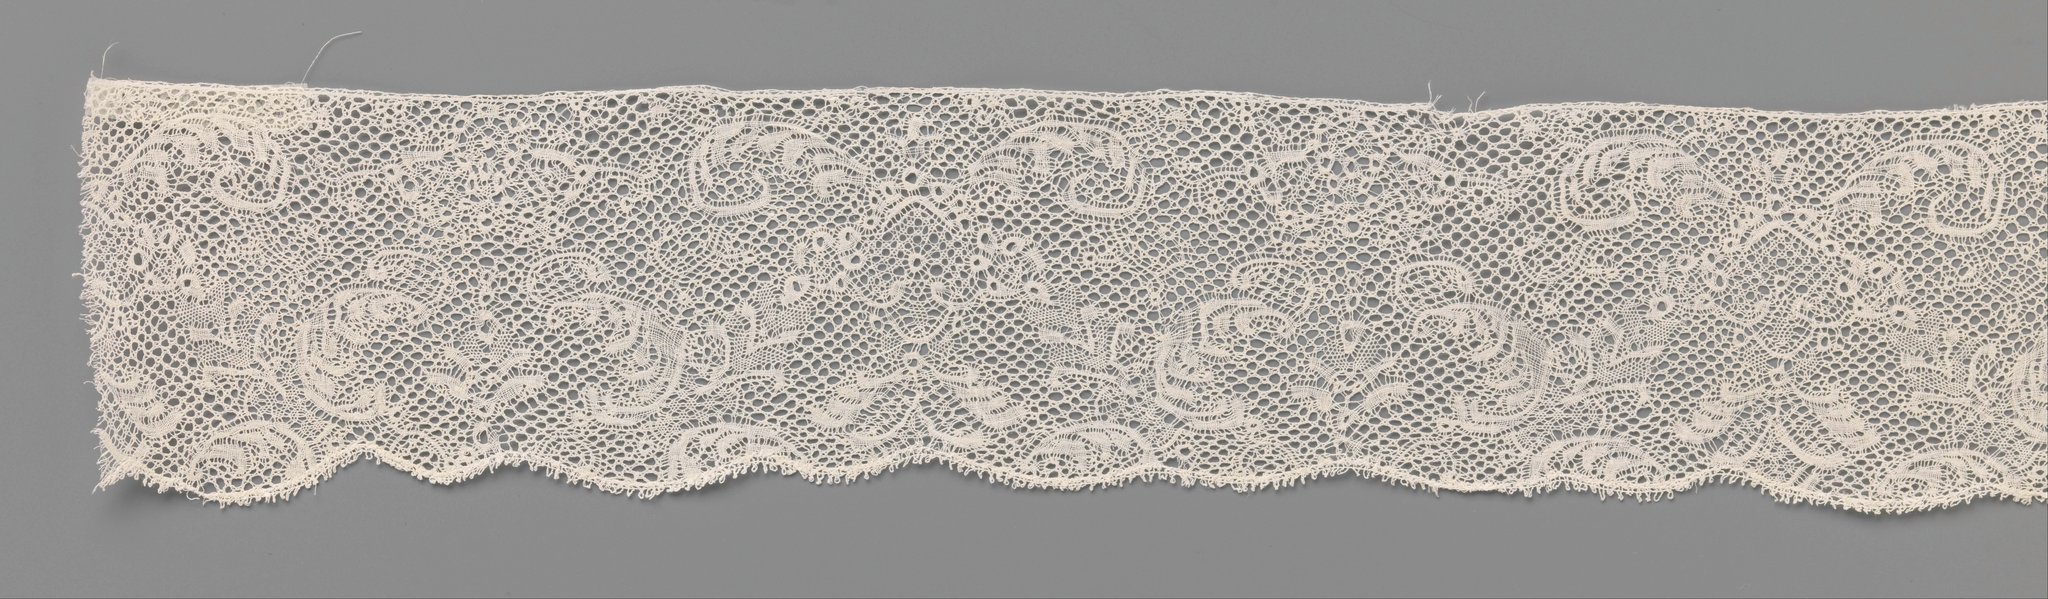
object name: strip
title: Strook kloskant met twee tegen elkaar geplaatste driehoekige composities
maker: Anonymous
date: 1690-1710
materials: linen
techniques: lace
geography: southern netherlands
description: Strook naturelkleurige kloskant, Binche-kant. Het zich herhalende en ijle patroon bestaat uit twee verschillende composities, beide symmetrisch en driehoekig. De schuine lijnen van de ene compositie bestaan uit in elkaar geschoven v-vormige blaadjes. Een omgekeerd hart vormt de top van de driehoek, die wordt bekroond door twee grote gevederde voluutbladeren. In de andere compositie zorgen dergelijke voluutbladeren voor de schuine lijnen van de driehoek, die wordt bekroond door een niet duidelijk definieerbaar, samengesteld motief. In beide driehoekige velden bevindt zich een kandelabermotief. De motieven zijn gemaakt in linnenslag met opengewerkte randjes en in netslag. Ze zijn met elkaar verbonden door een traliegrond, een vijfgaatjesgrond. Verschillende siergronden zijn toegepast, in onder andere het hart, in één van de kandelabermotieven en onder c-voluten. De bovenzijde van de strook is recht afgewerkt. De flauw geschulpte onderzijde is afgewerkt met picots. De schulpen lijken geen onderdeel te zijn van het oorspronkelijke patroon, de motieven van de onderzijde worden er door afgebroken en de picots zijn met een afwijkende draad gemaakt.